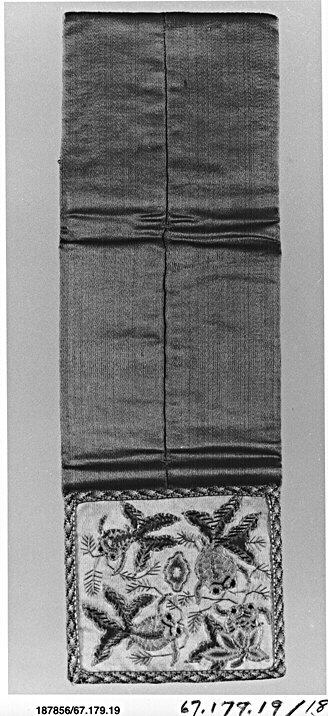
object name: case, card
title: Card Case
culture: chinese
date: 1801-1900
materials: metal thread, silk